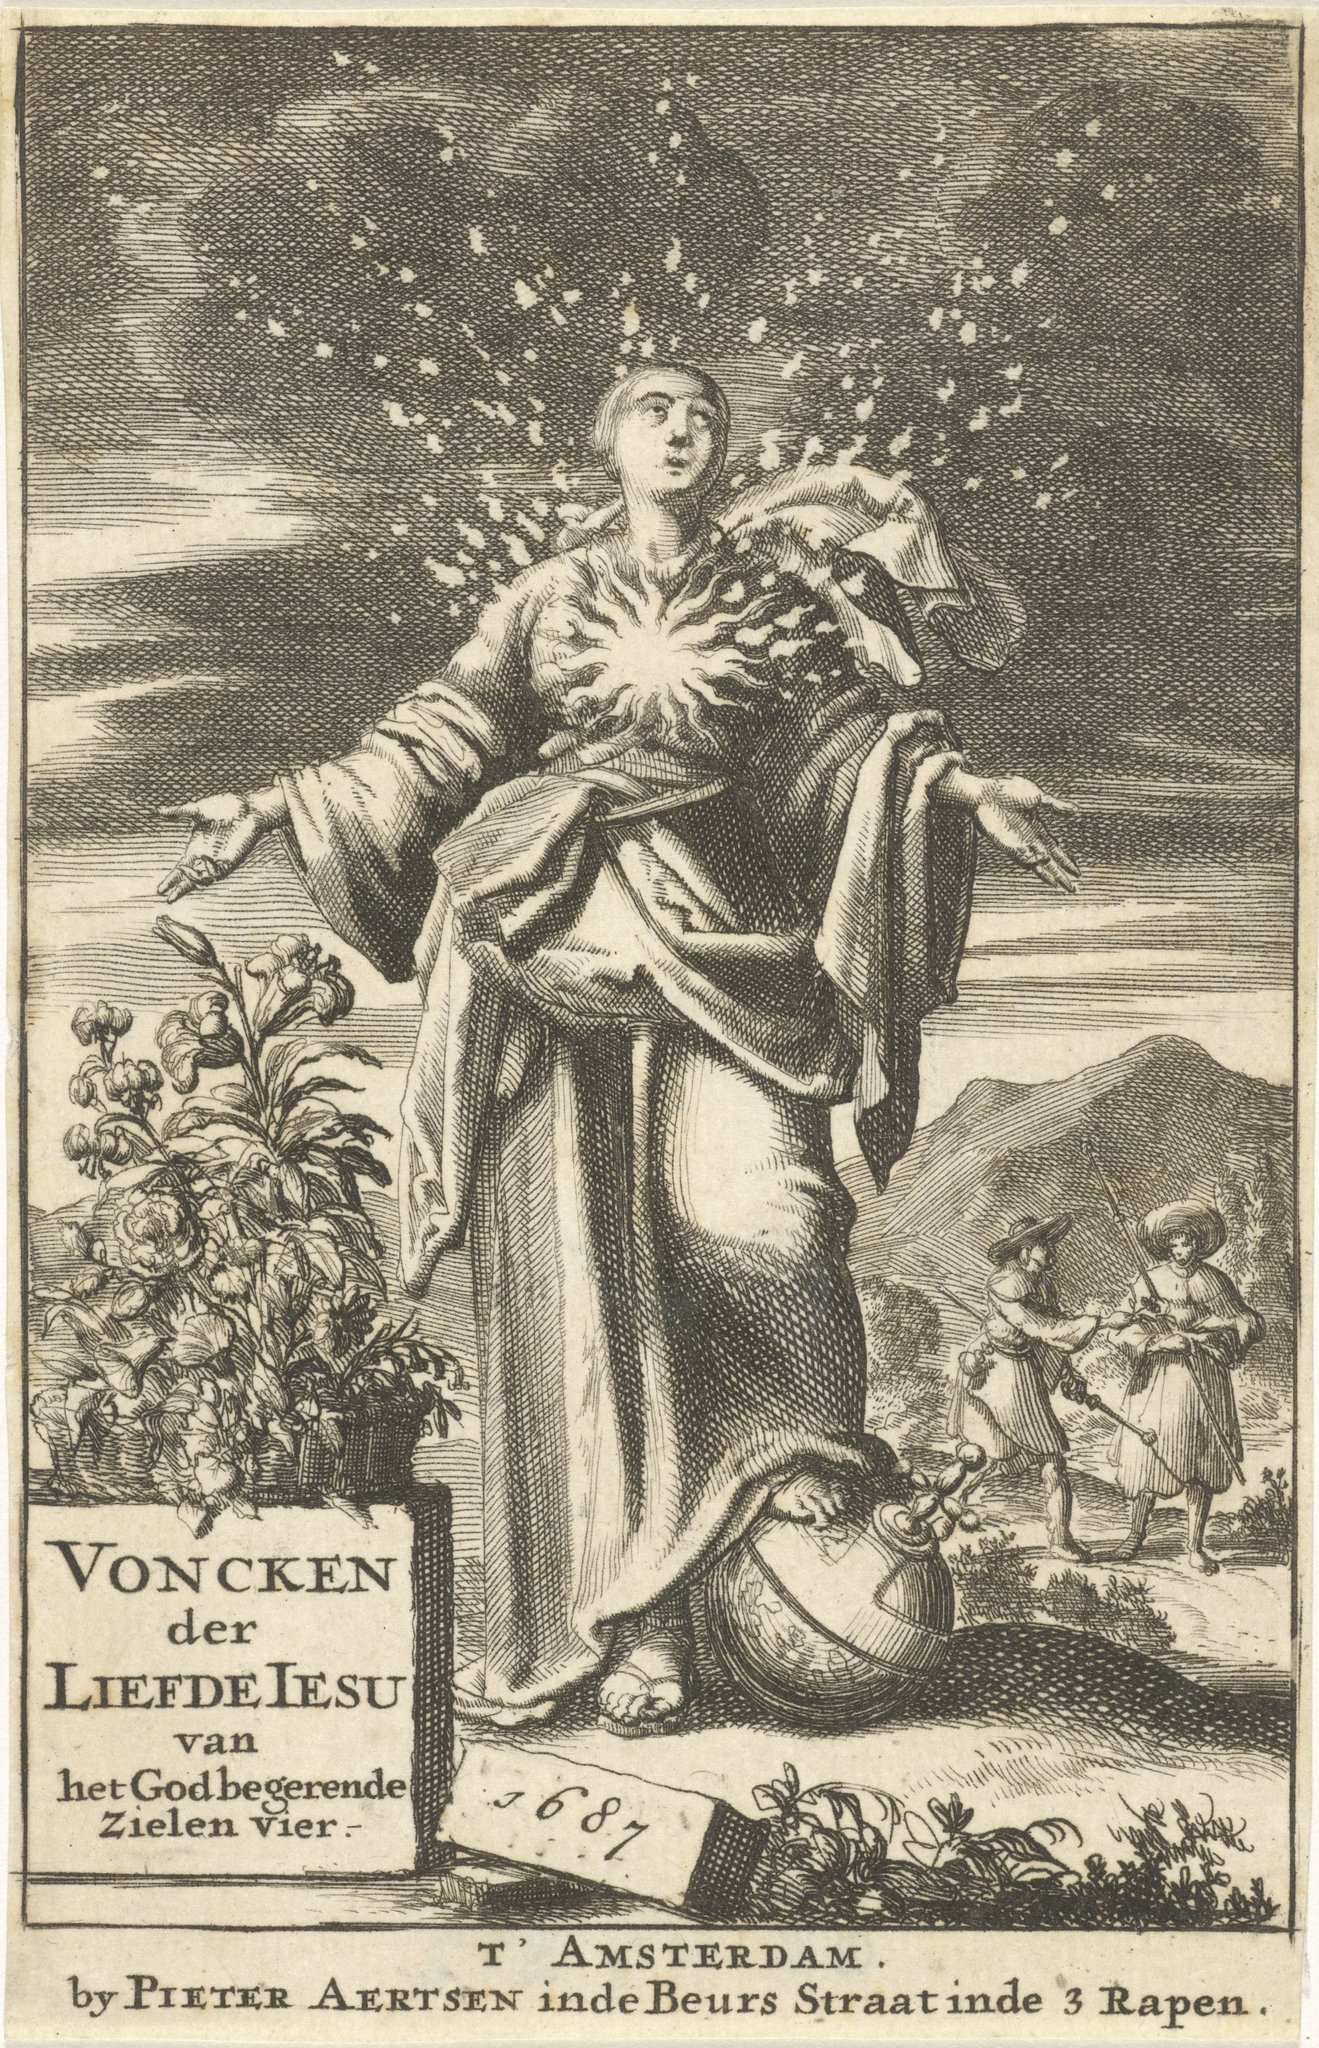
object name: titelblad, titelpagina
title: Titelpagina voor: J. Luyken, Voncken der liefde Jesu, van het godtbegerende zielenvier, 1687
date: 1687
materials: paper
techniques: etching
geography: amsterdam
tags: orb (symbol of sovereignty; sphere with cross on top), the sacred heart, pilgrimage, pilgrim(s) under way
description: Titelpagina voor: Luyken, Jan. Voncken der liefde Jesu, van het godtbegerende zielenvier. Amsterdam: Pieter Arentsz (II), 1687. Vgl. Van Eeghen 834.